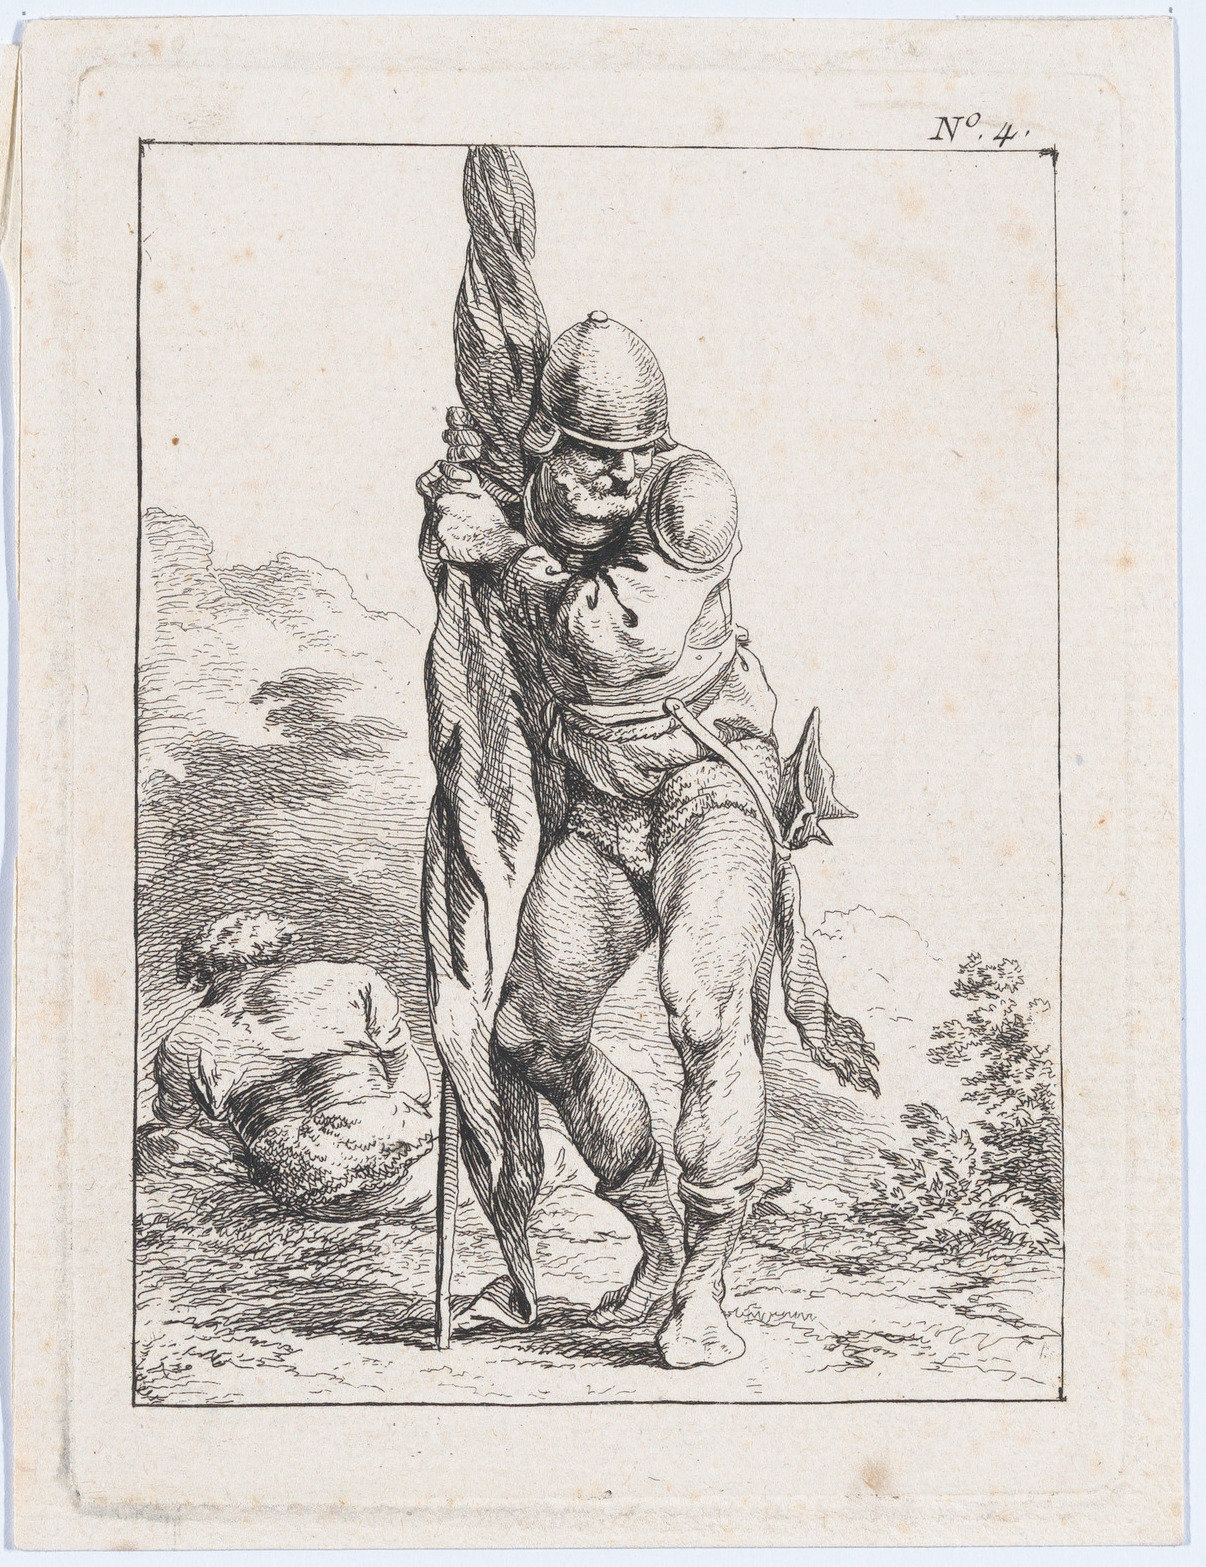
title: Standing Soldier Holding a Rolled Flag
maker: philippe jacques de loutherbourg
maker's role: artist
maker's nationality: french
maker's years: 1740-1812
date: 1755-1771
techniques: etching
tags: soldiers,men